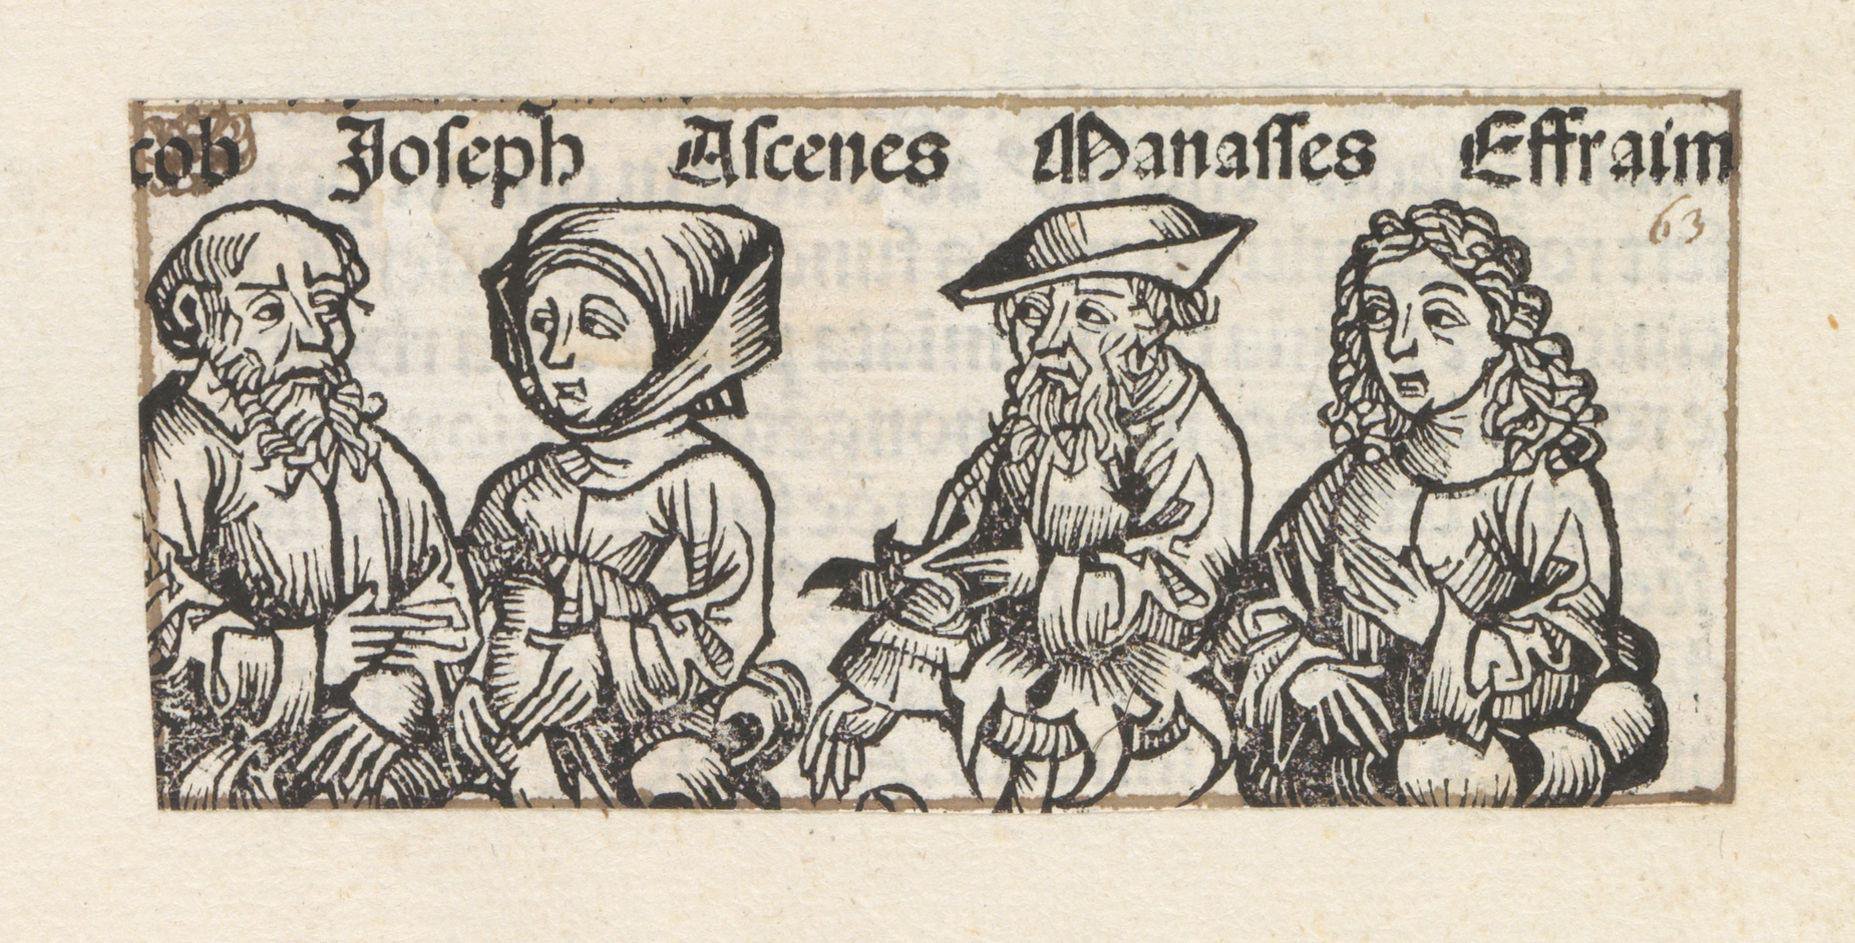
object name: album leaf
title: Liber Chronicarum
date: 1493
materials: paper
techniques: letterpress printing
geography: nuremberg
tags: persons from the old testament (not in biblical context, nor occurring in legendary/historical extensions included in division 71)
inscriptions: inscription: ‘63’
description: Drie bloemkelken met links Jozef en zijn vrouw Asnat. De tekst identificeert de mannen rechts als hun kinderen Efraïm en Manasse. De voorstelling is een fragment van de stamboom van Christus in de Liber Chronicarum. De prent maakt deel uit van een album.